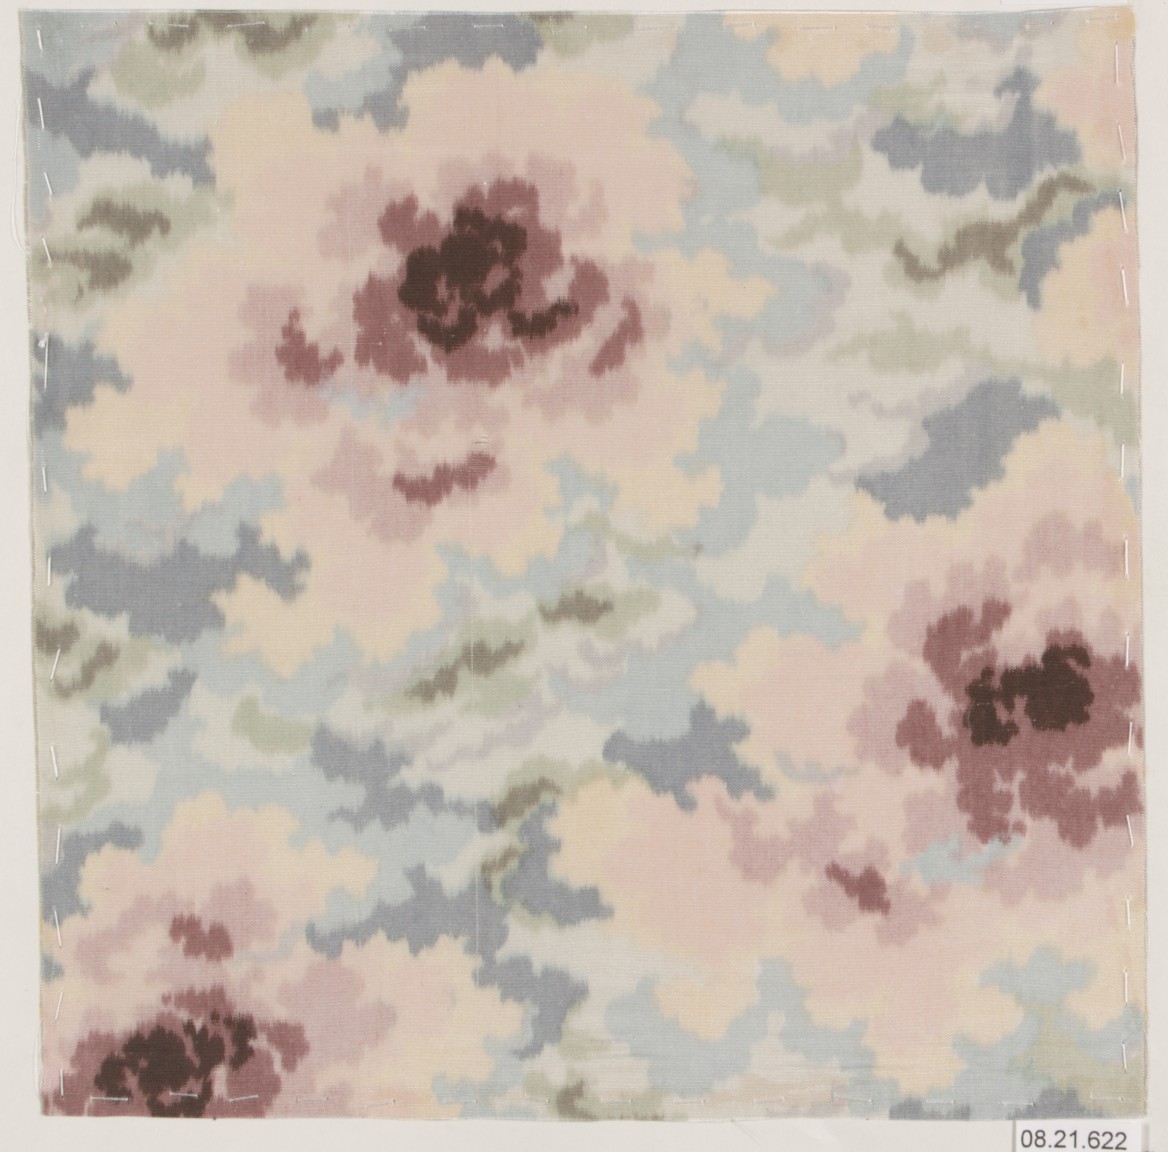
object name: textile sample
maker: Anonymous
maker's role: designer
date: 1900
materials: silk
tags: flowers